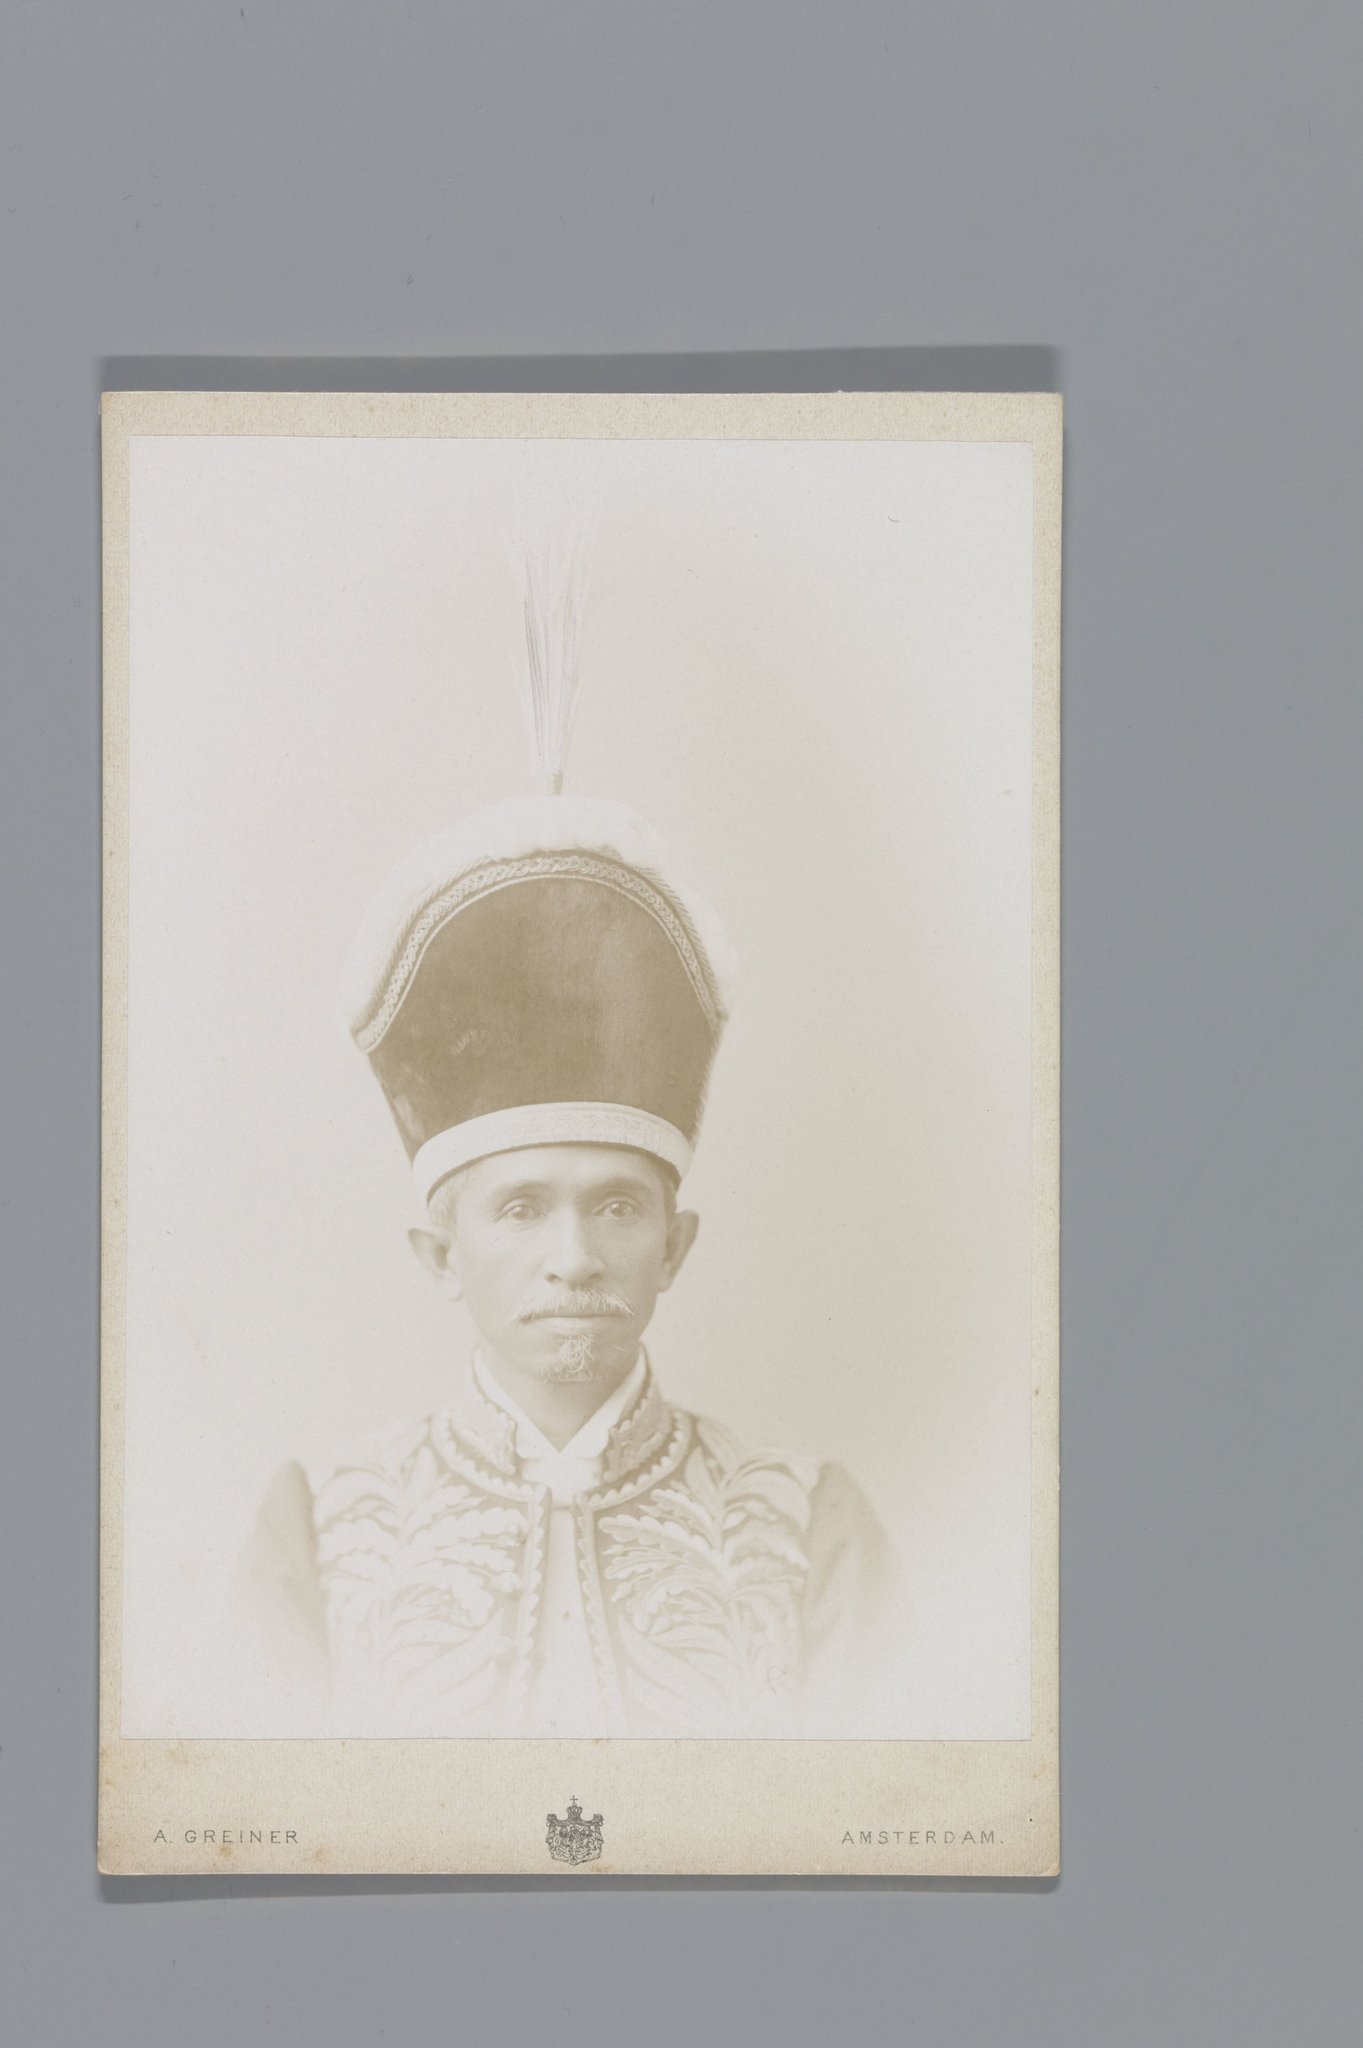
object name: photograph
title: Javaanse prins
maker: albert greiner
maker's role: fotograaf, fotostudio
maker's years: 1833-1890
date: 1860-1915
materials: cardboard, paper, photographic support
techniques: collodion silver print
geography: netherlands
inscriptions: inscription